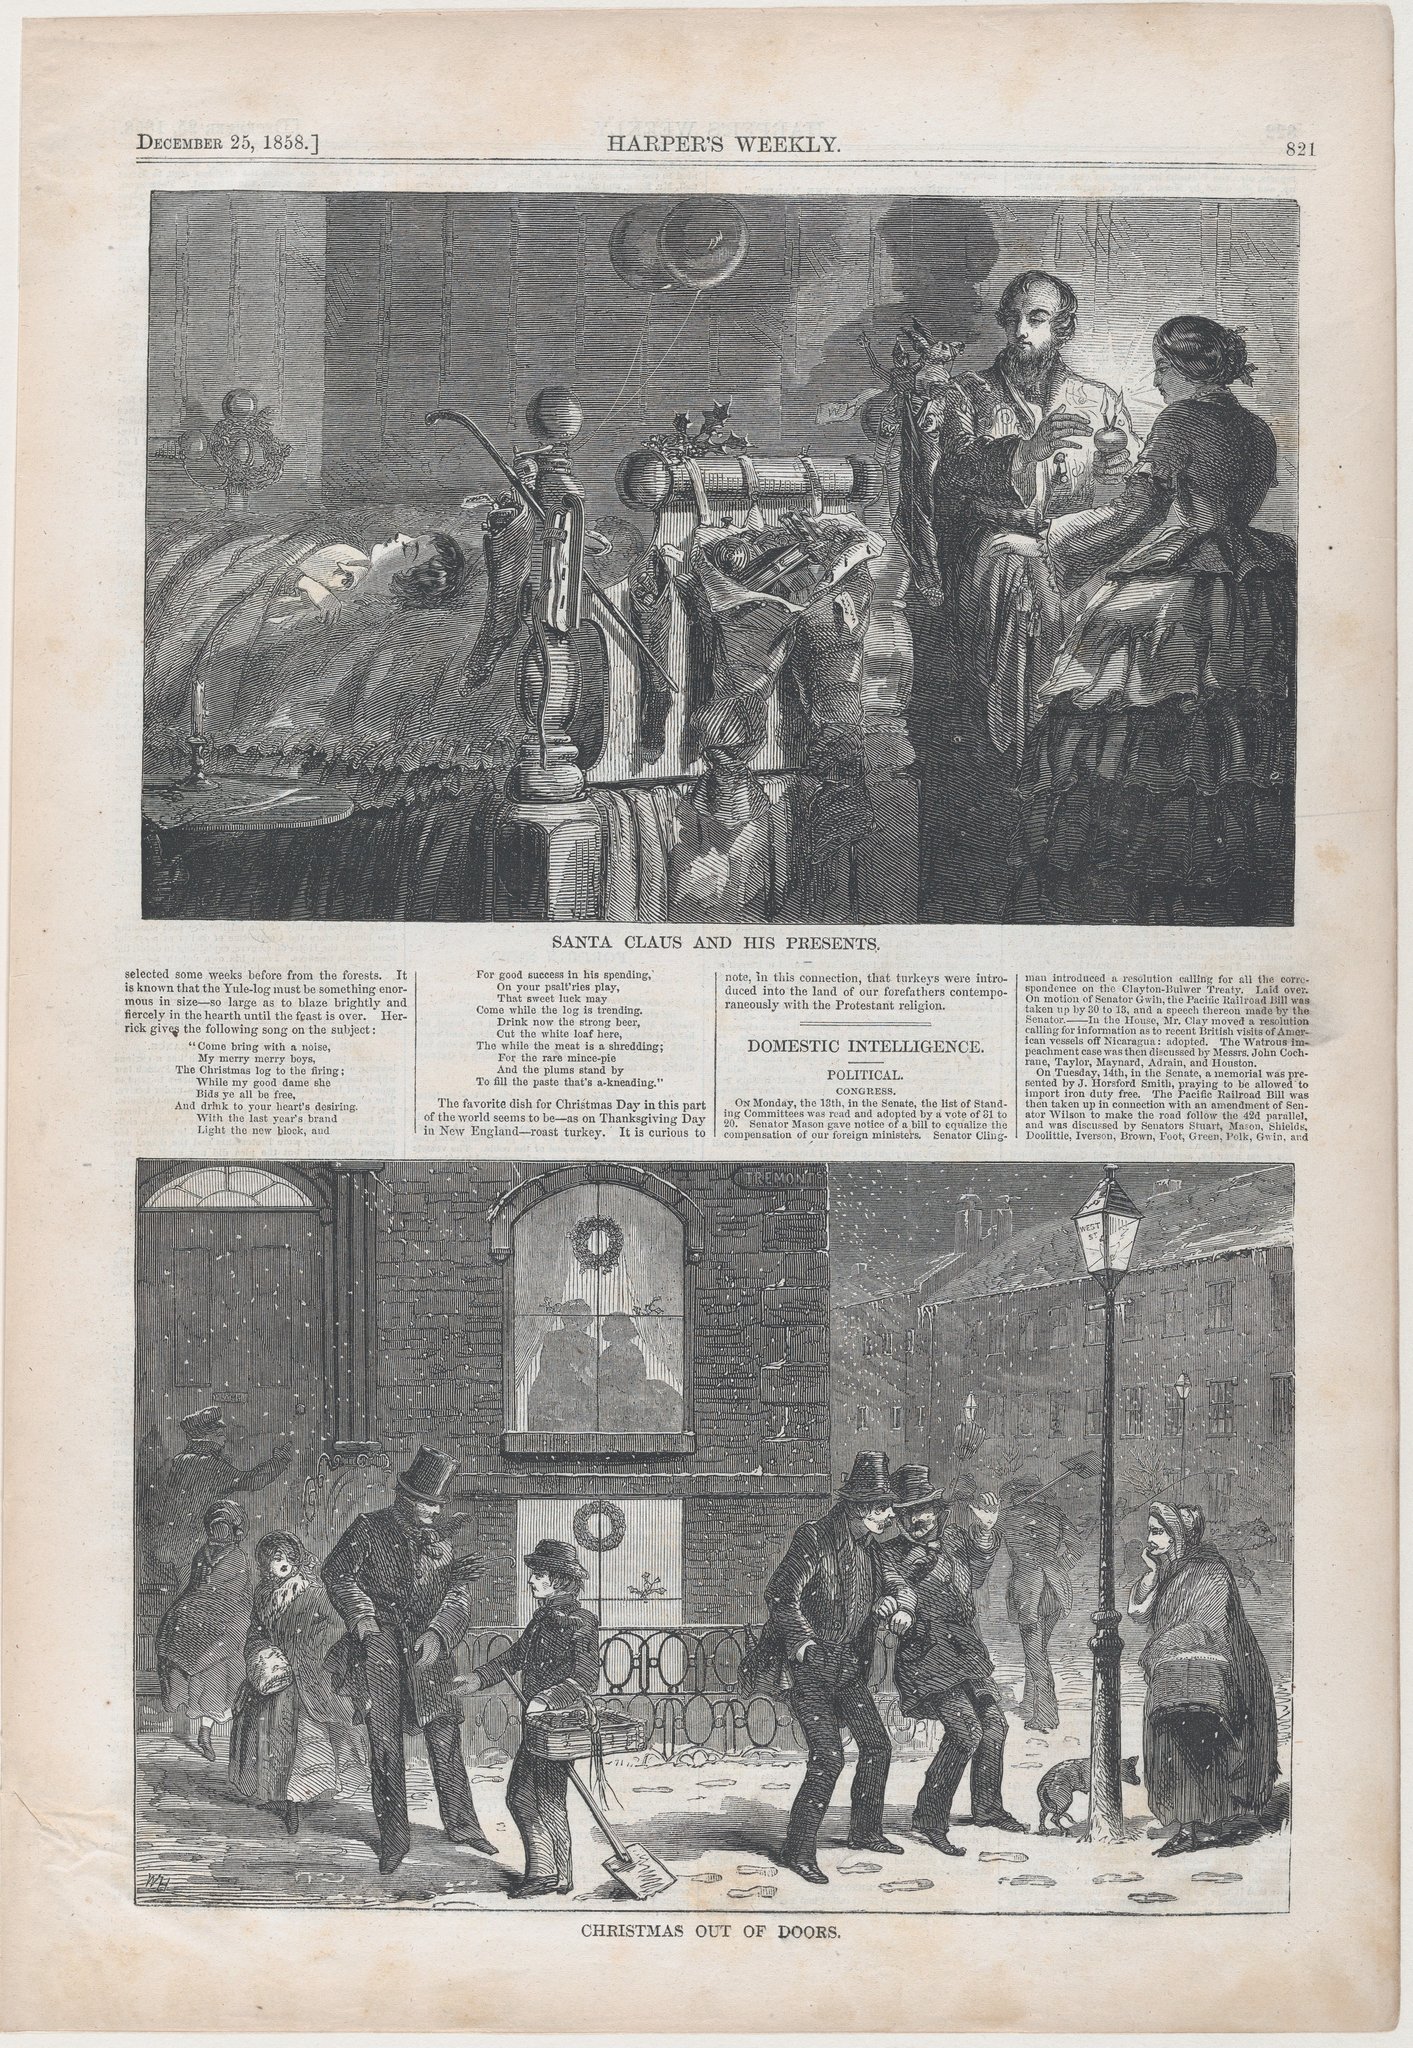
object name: print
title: Christmas Out of Doors (from "Harper's Weekly," Vol. II)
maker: winslow homer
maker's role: artist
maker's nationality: american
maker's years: 1836-1910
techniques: engraving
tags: men,women,christmas